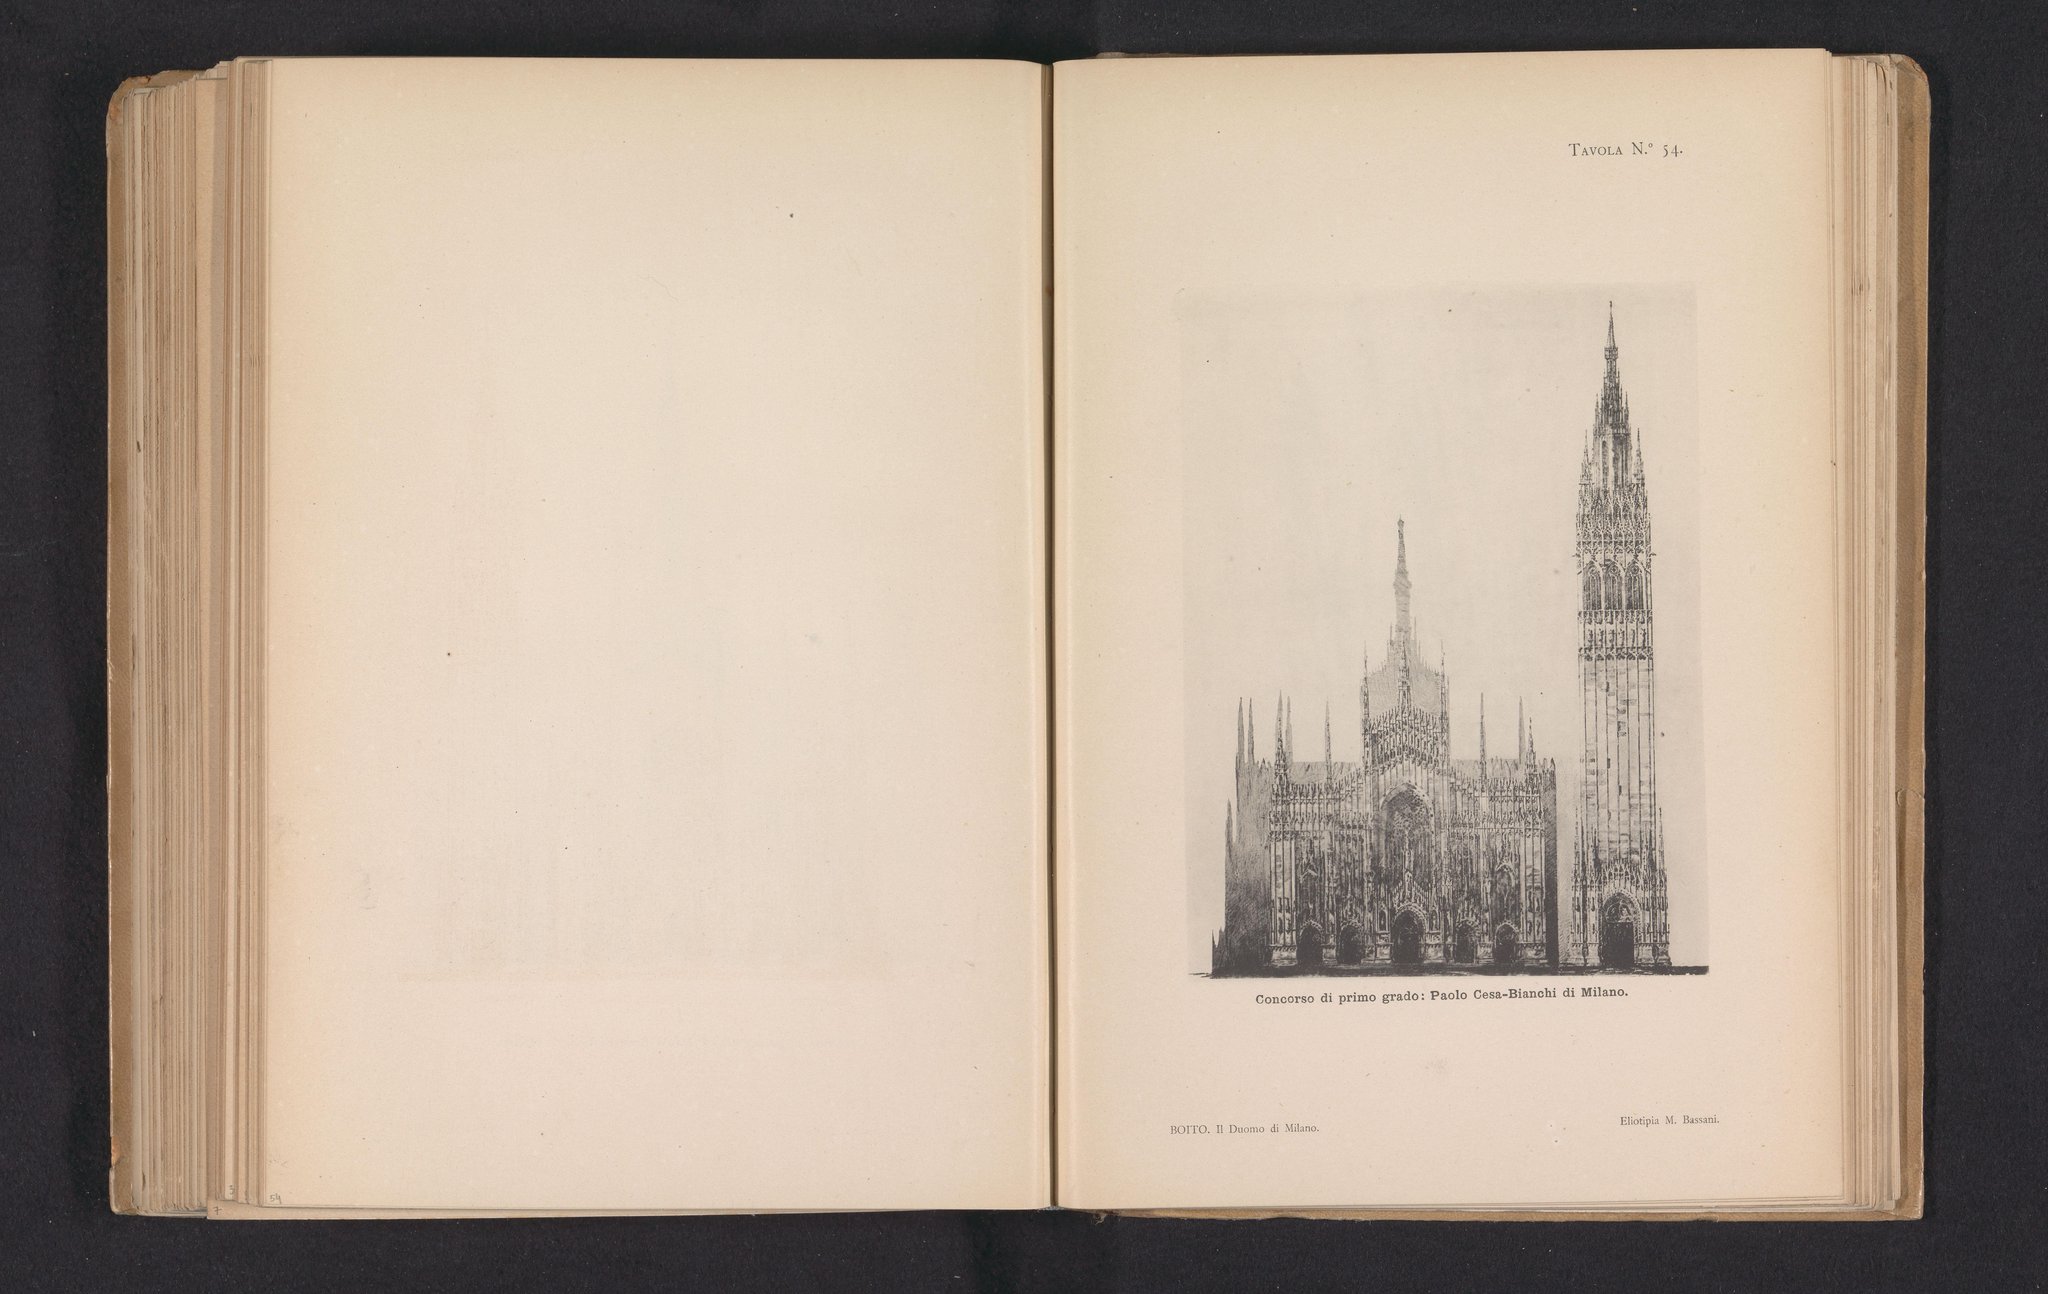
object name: reproduction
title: Concorso di primo grado : Paolo Cesa-Bianchi di Milano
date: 1886-1889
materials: paper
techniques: photograph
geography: milan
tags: drawing, sketch, church (exterior)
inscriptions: number: ‘Tavola No. 54.’